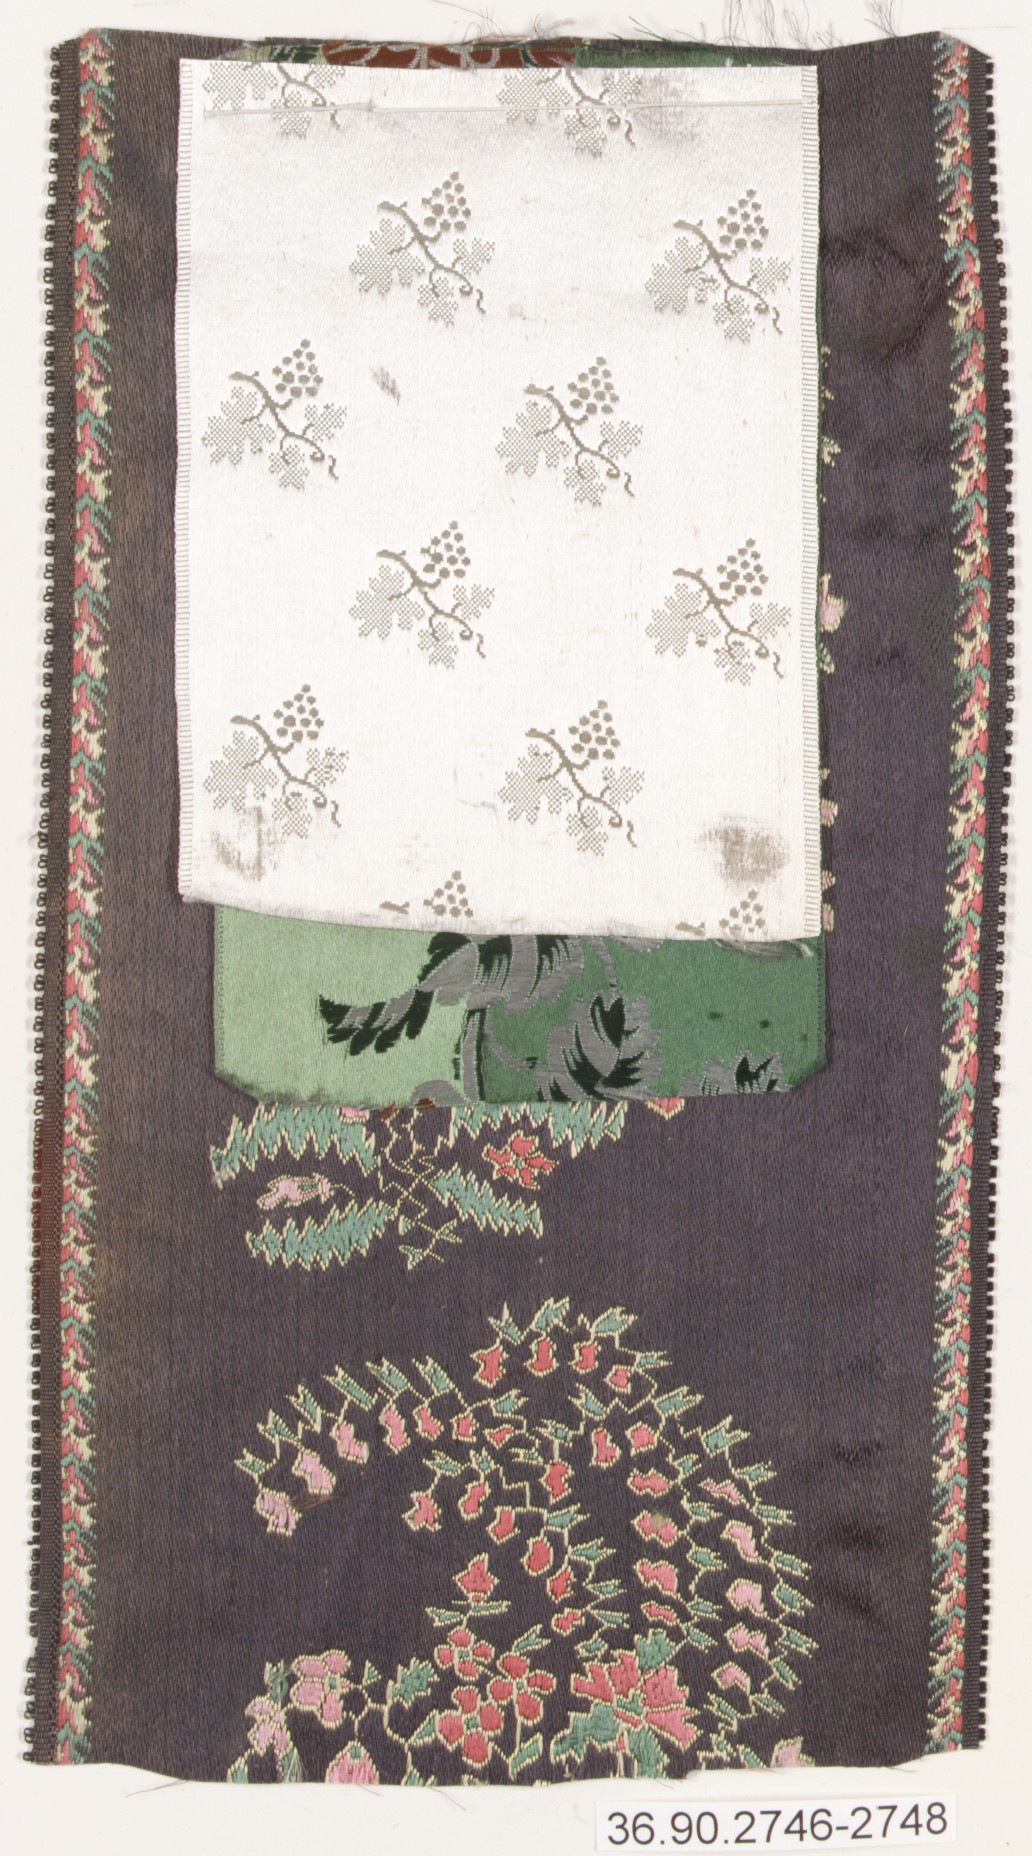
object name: ribbon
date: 1801-1900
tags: flowers